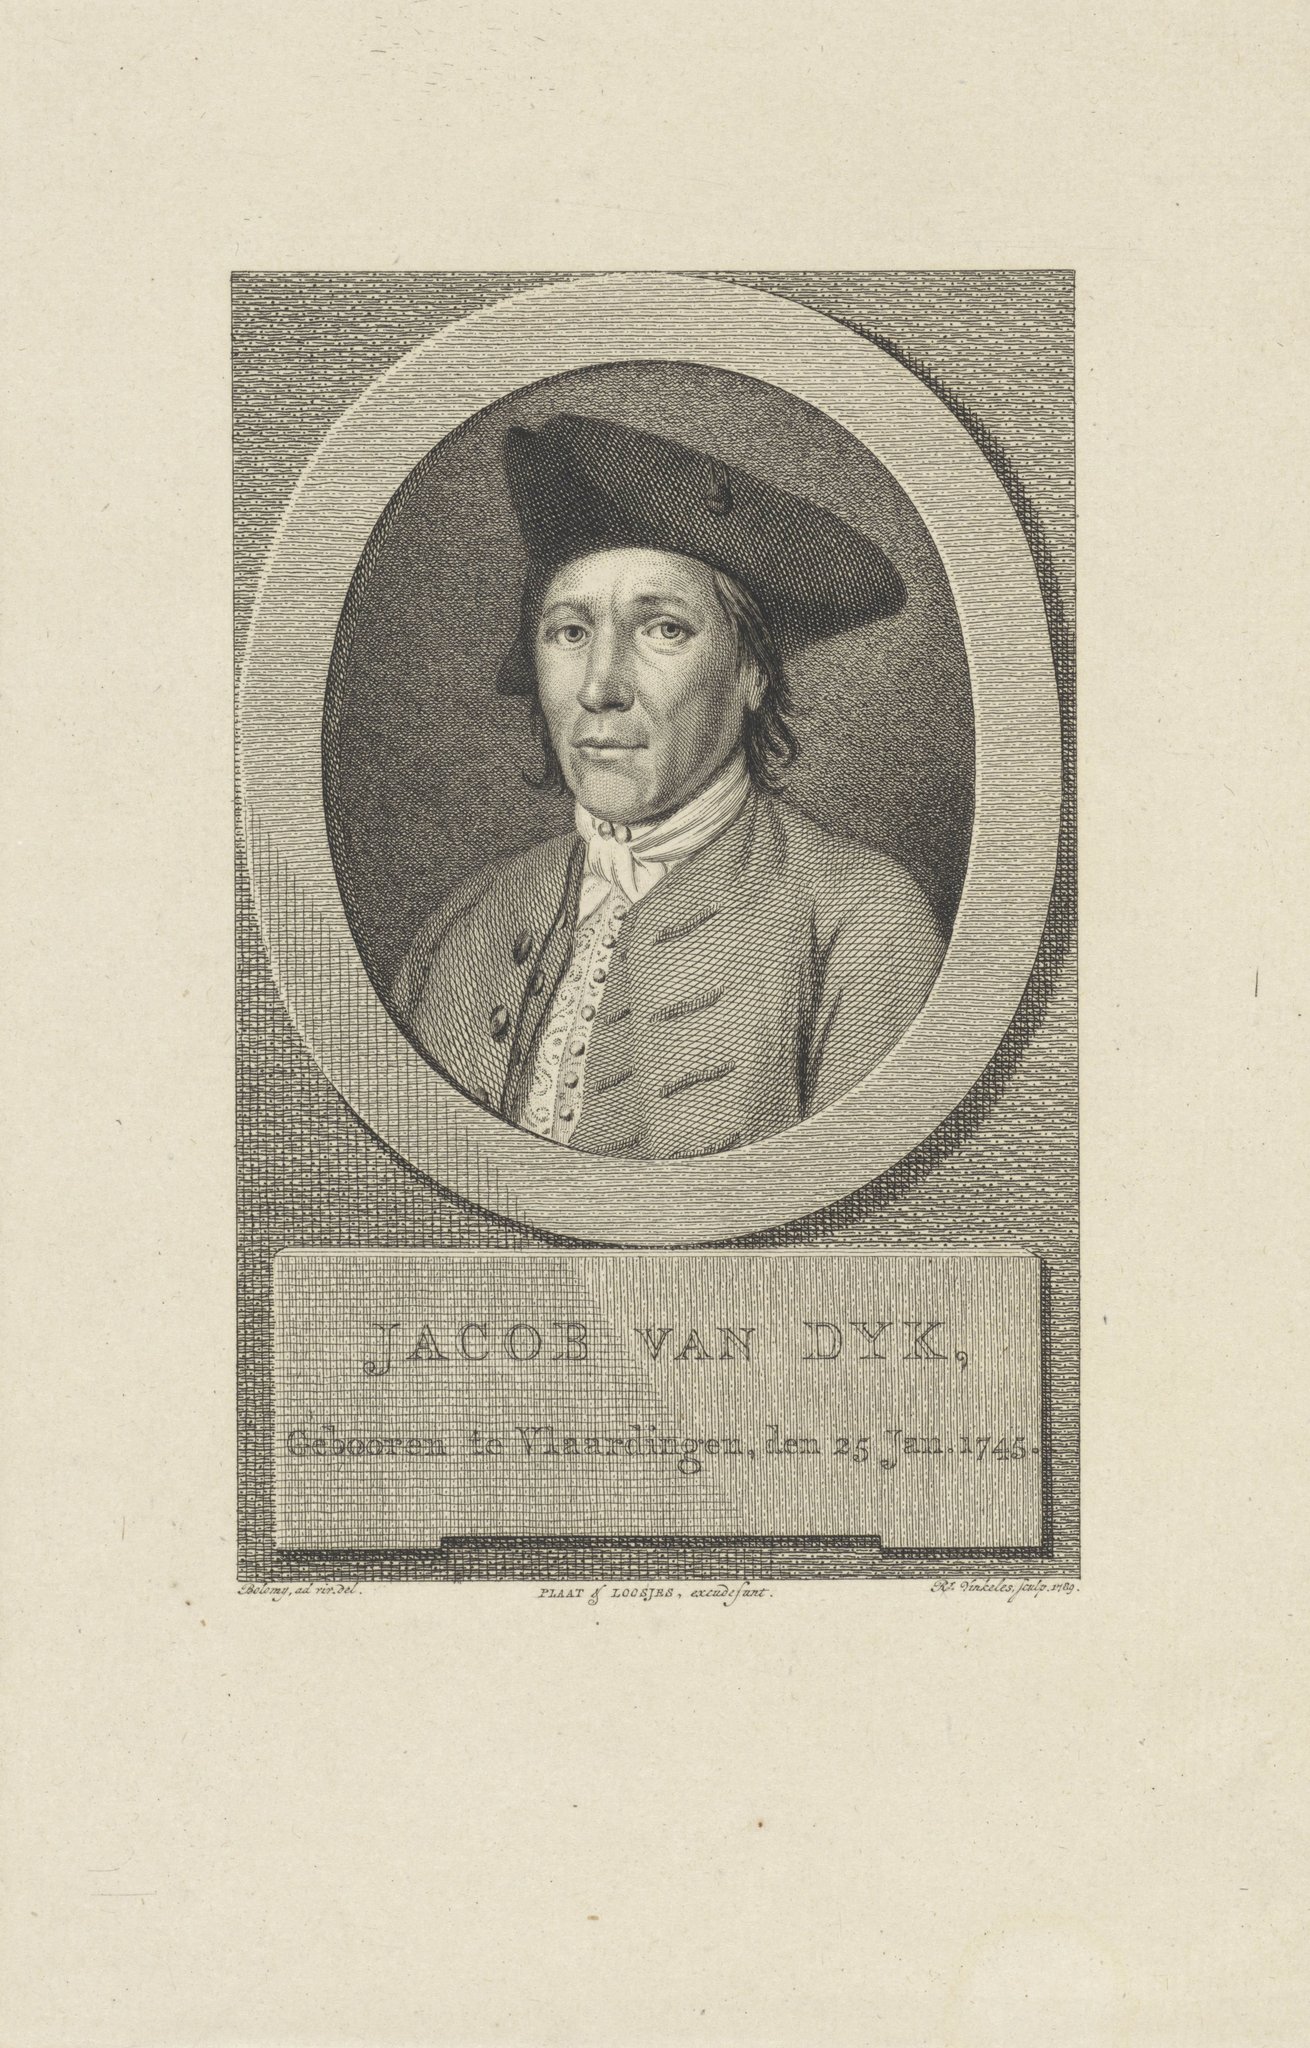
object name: print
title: Portret van Jacob van Dyk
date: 1789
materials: paper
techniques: etching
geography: haarlem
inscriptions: collector's mark: Lugt 2228